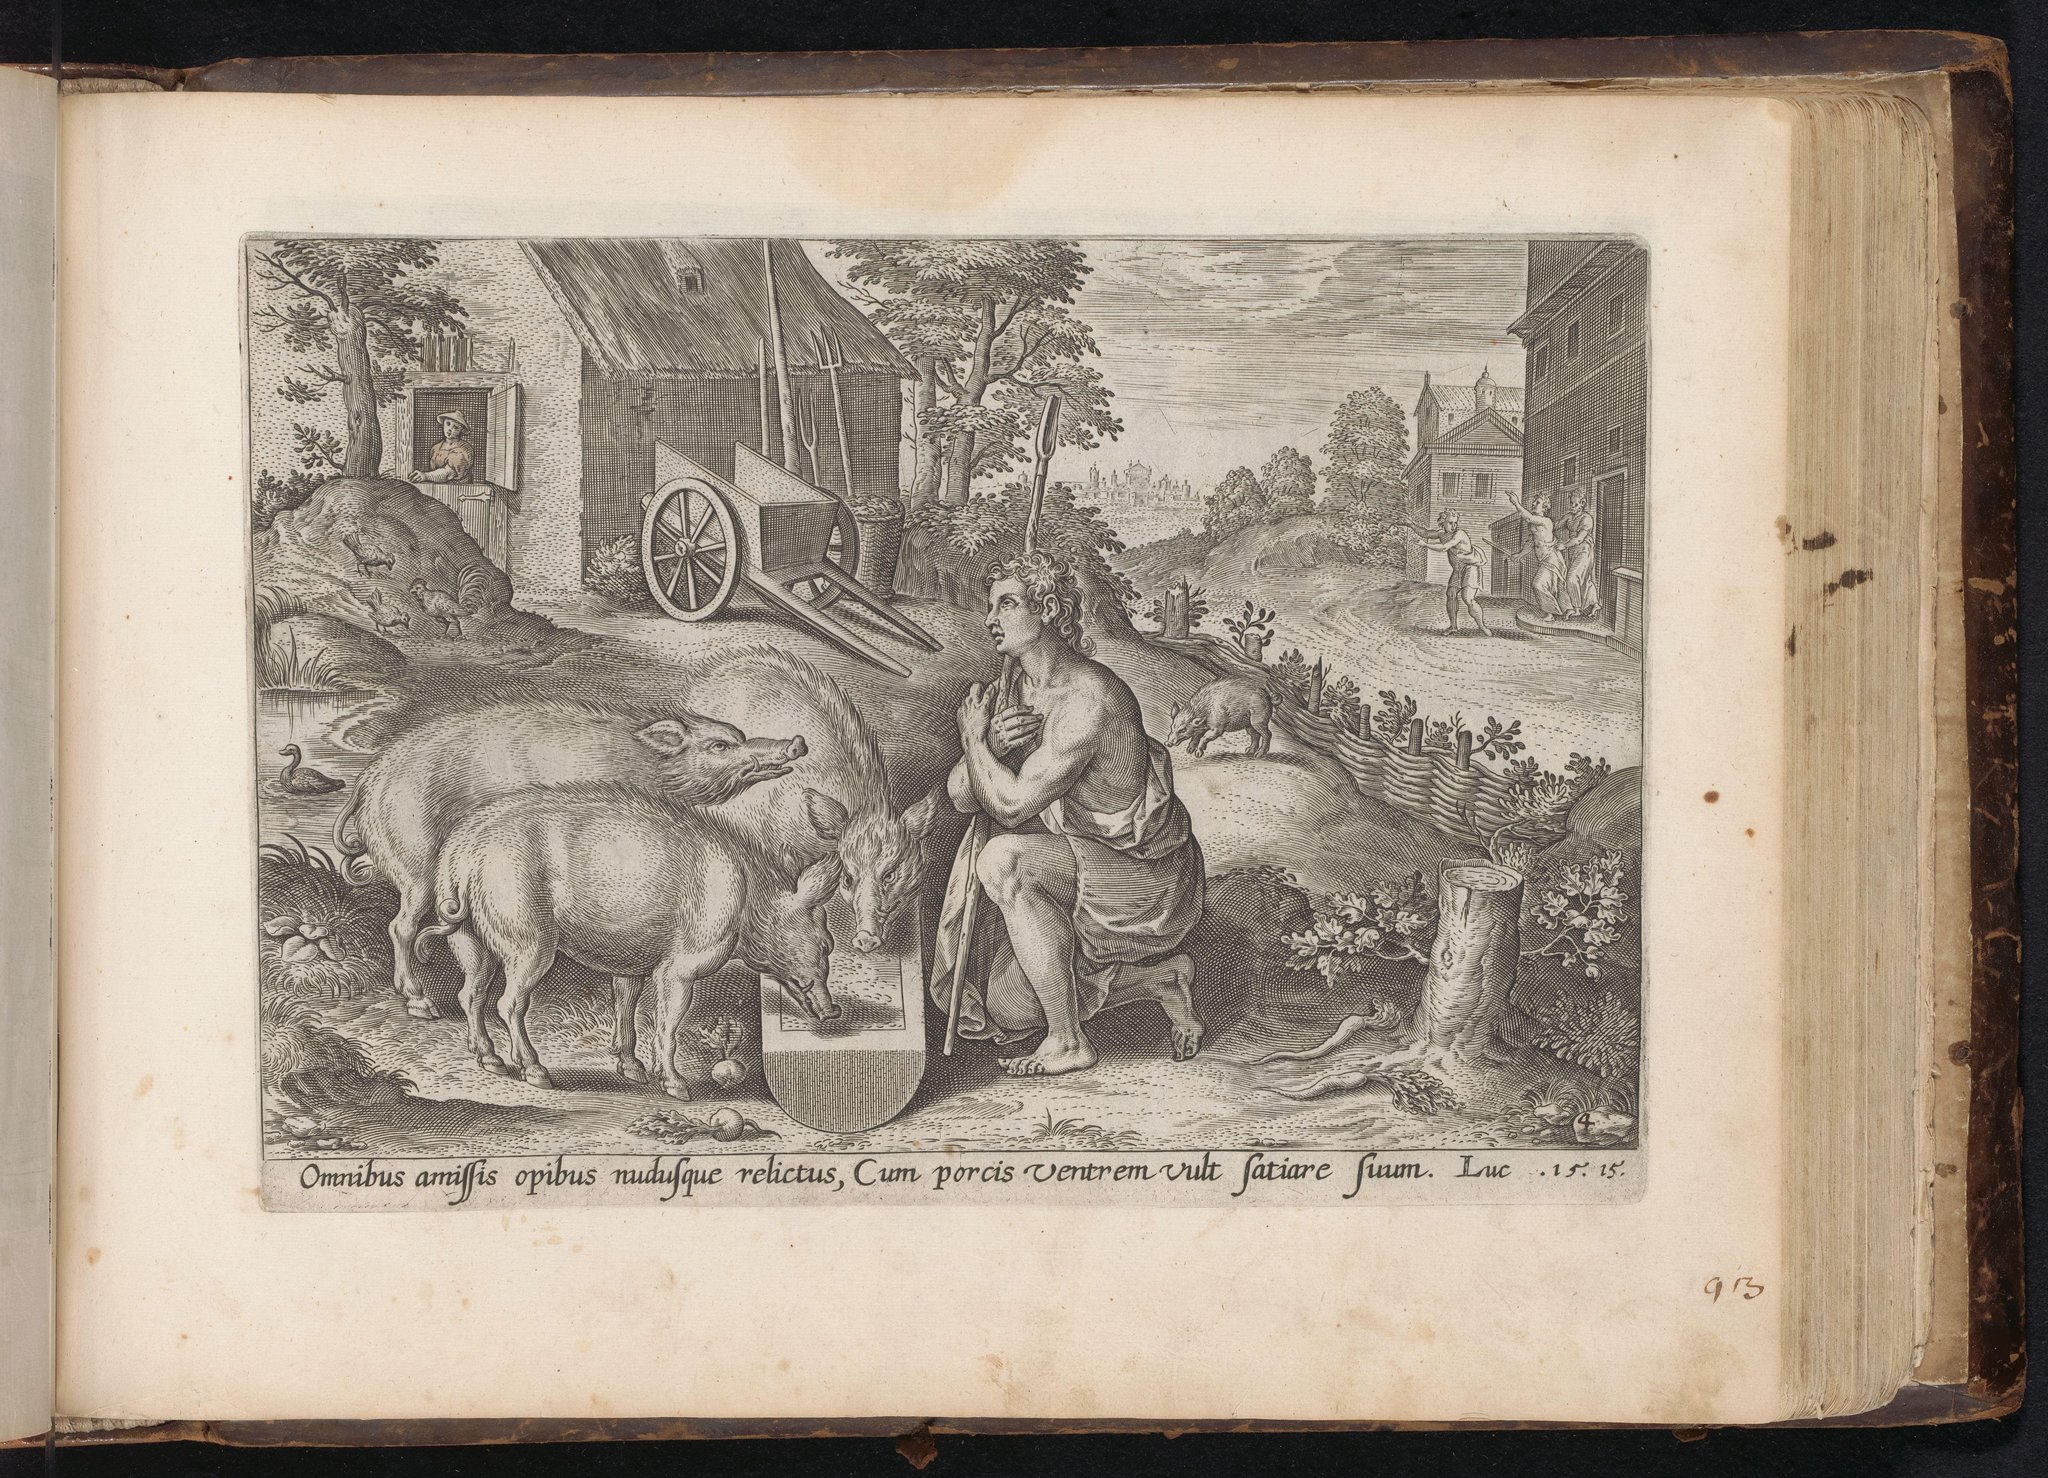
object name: album leaf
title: Gelijkenis van de verloren zoon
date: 1585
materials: paper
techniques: engraving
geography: amsterdam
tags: when all his money is squandered the prodigal son is chased away by the harlots, the prodigal son tends the swine and eats from their trough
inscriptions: serial number: ‘4’, number: ‘93’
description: De verloren zoon heeft zijn erfenis verkwist en werkt bij een boer als varkenshoeder. Hij knielt bij de varkens en eet met hen samen uit de voederbak. Rechts op de achtergrond wordt de verloren zoon uit het bordeel gejaagd, omdat zijn geld op is. Onder de voorstelling een verwijzing in het Latijn naar de Bijbeltekst in Luc. 15:15. Deze prent maakt deel uit van een album.